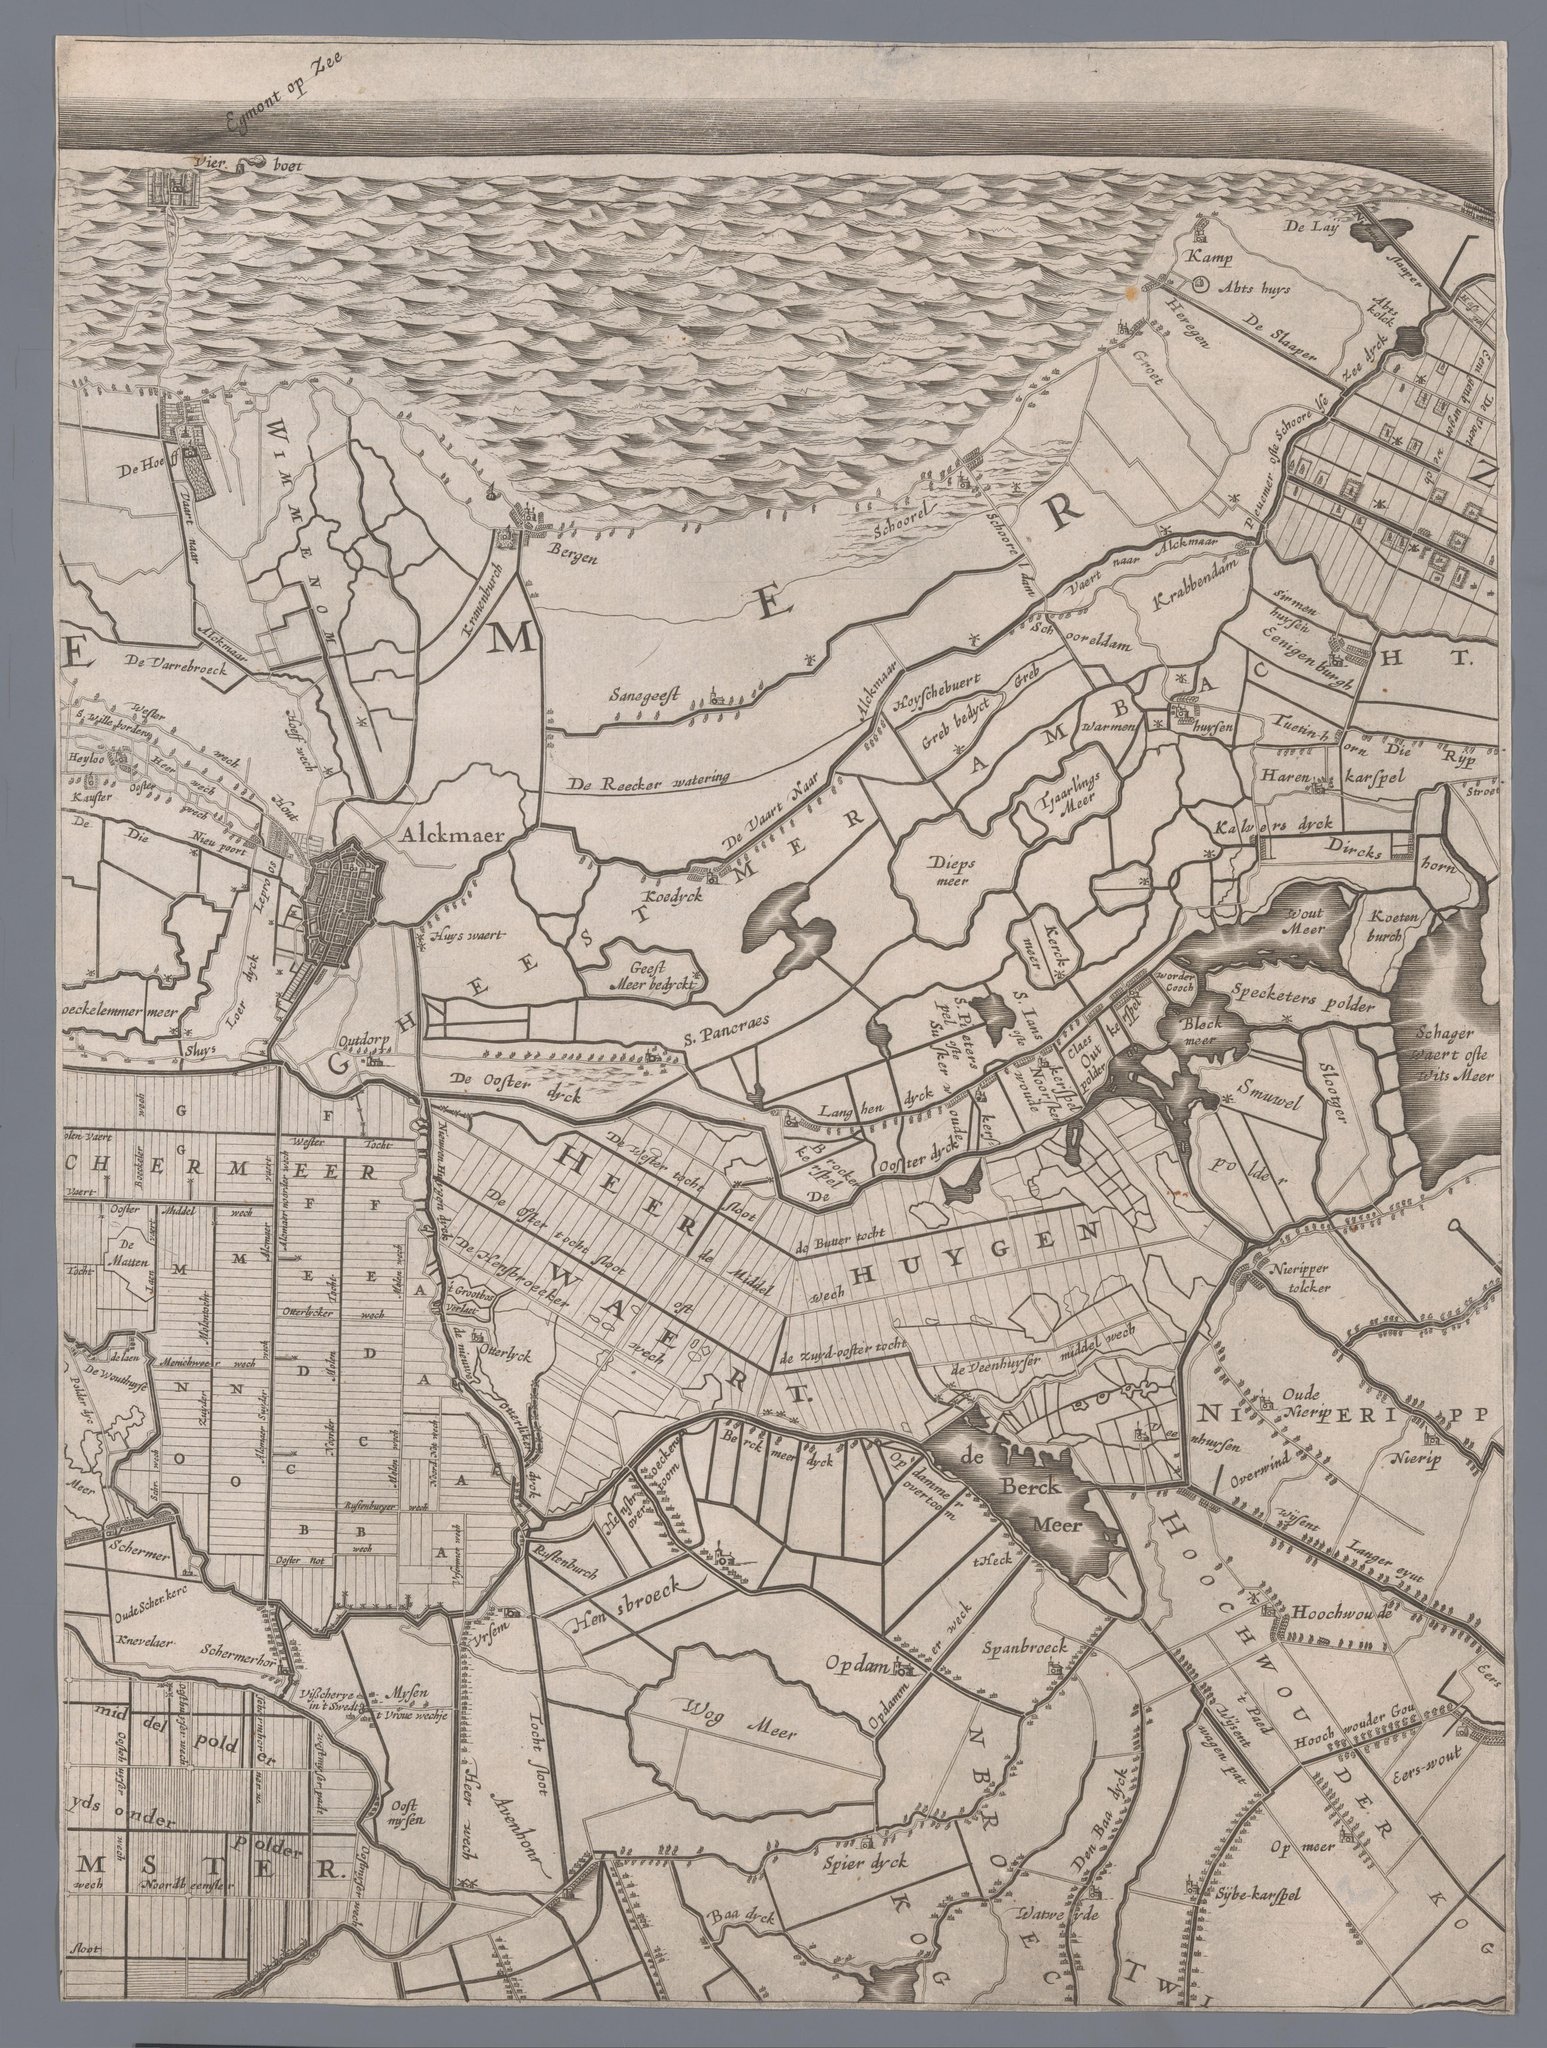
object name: print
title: Kaart van het Graafschap Holland en Utrecht (plaat 17)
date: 1639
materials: paper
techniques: engraving, etching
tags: maps, atlases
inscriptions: collector's mark: Lugt 2228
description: Onderdeel van een kaart samengesteld uit 40 bladen. Waarschijnlijk gaat het om de grootste kaart van Holland uit de zeventiende-eeuw. De kaart is uitgegeven in verschillende edities, deze kaart uit 1639 is de eerste editie.